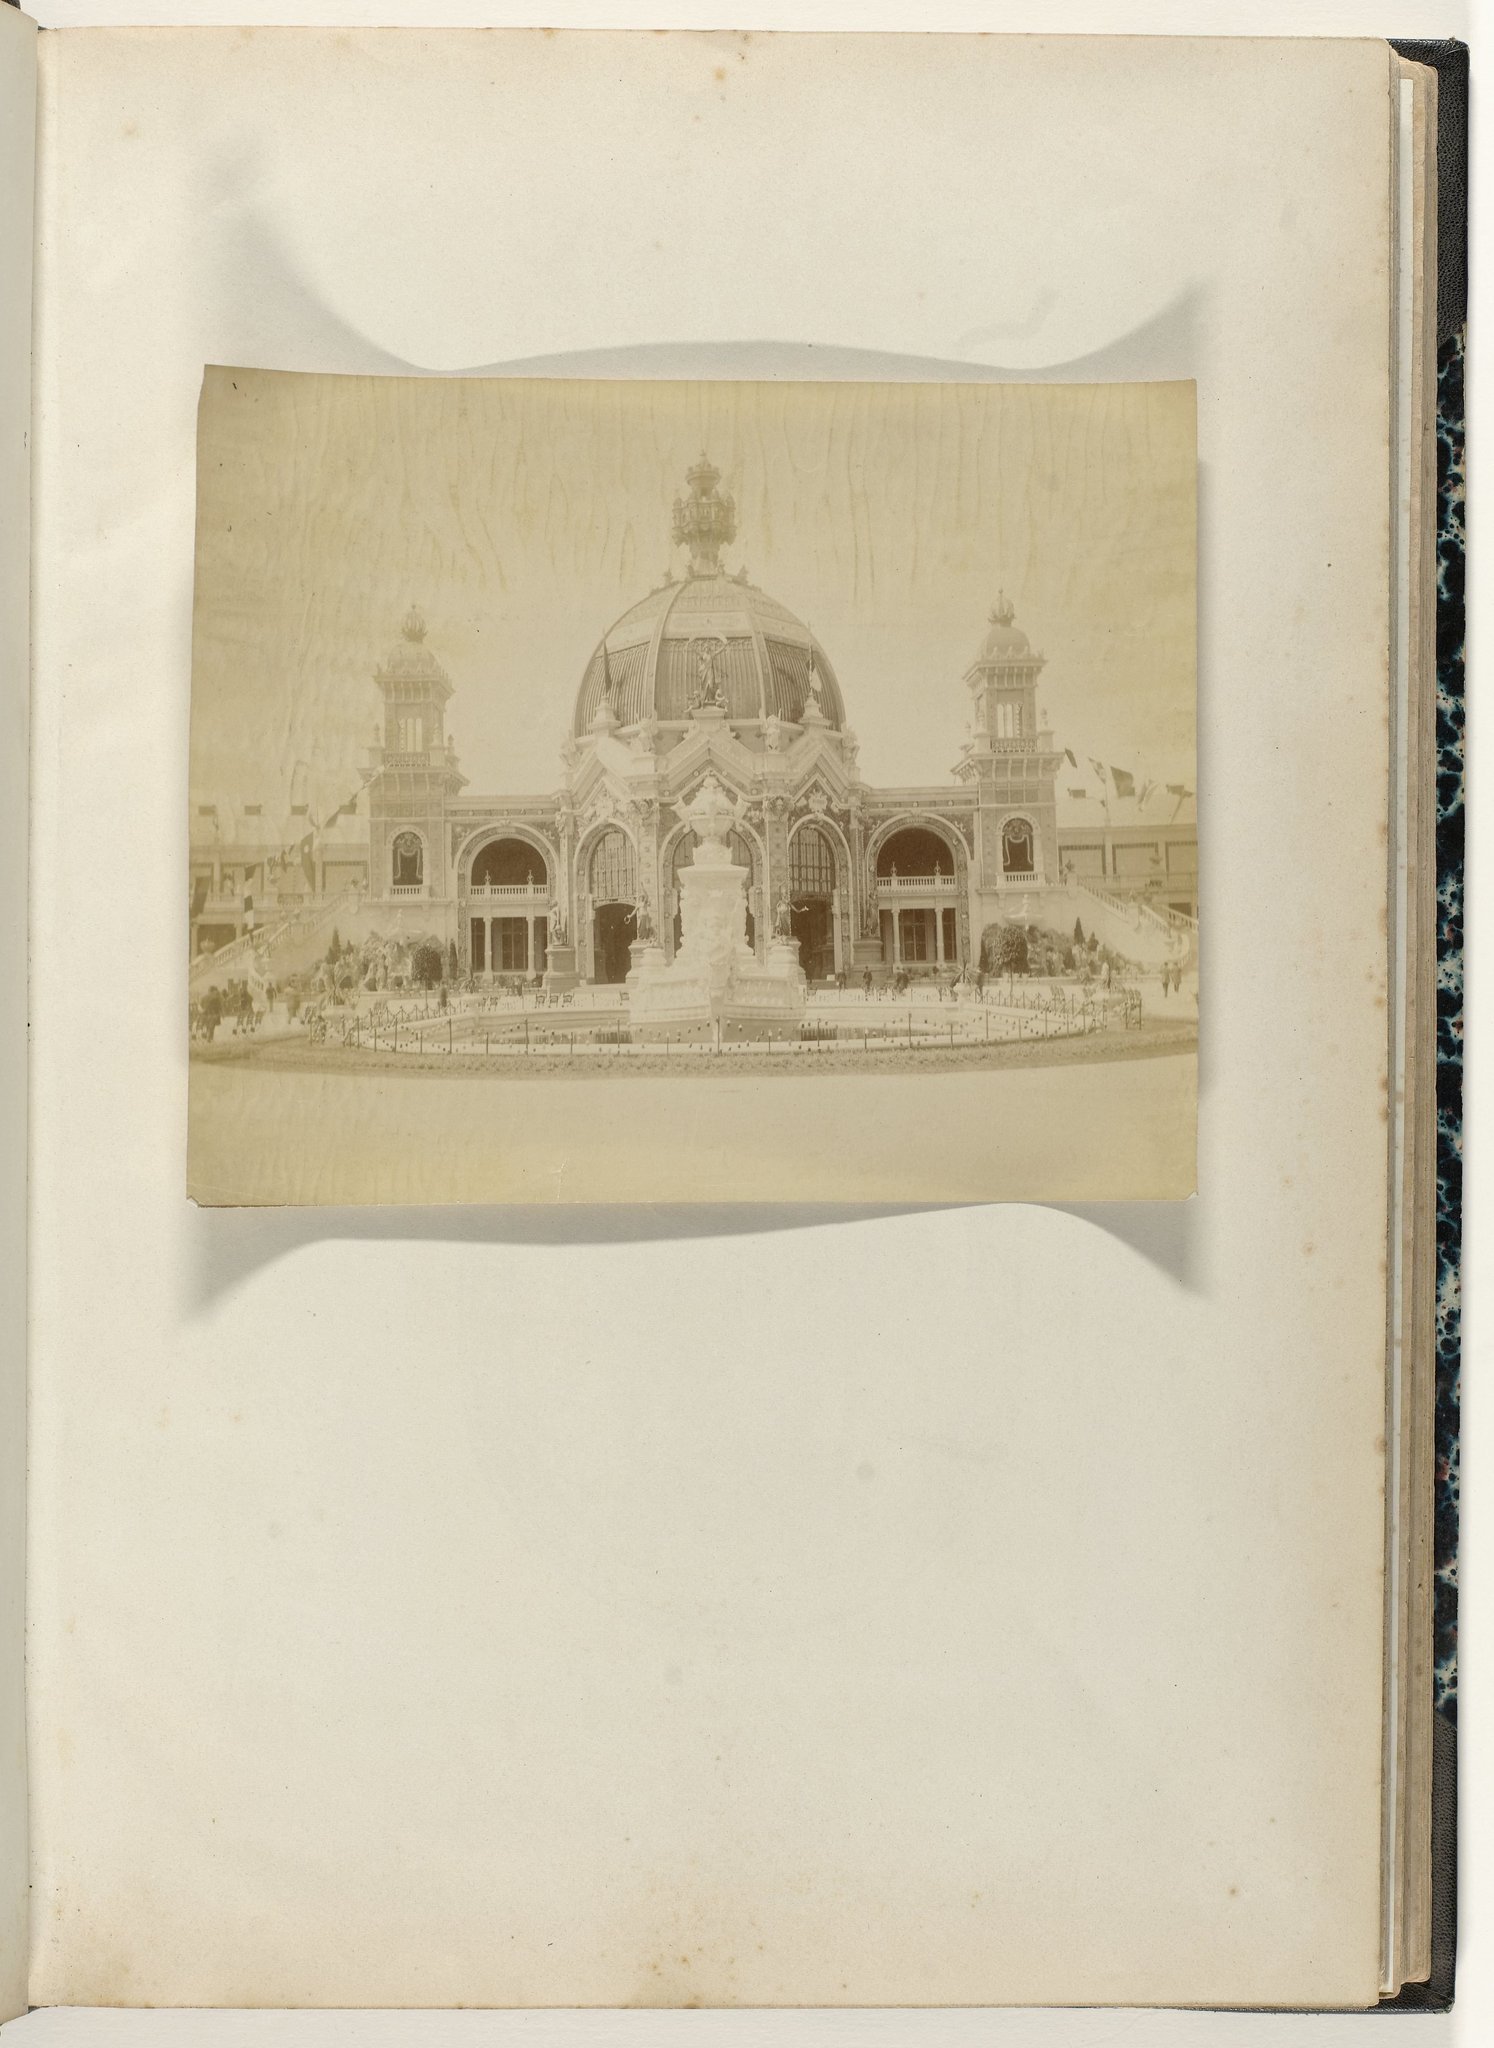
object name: photograph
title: Gebouw met fontein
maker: Anonymous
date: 1894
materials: paper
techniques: albumen print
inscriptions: annotation: ‘Anvers Exposition 1894’, name: ‘P.J. Kool’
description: Foto van gebouw, genomen tijdens de wereldtentoonstelling in 1894 te Antwerpen.